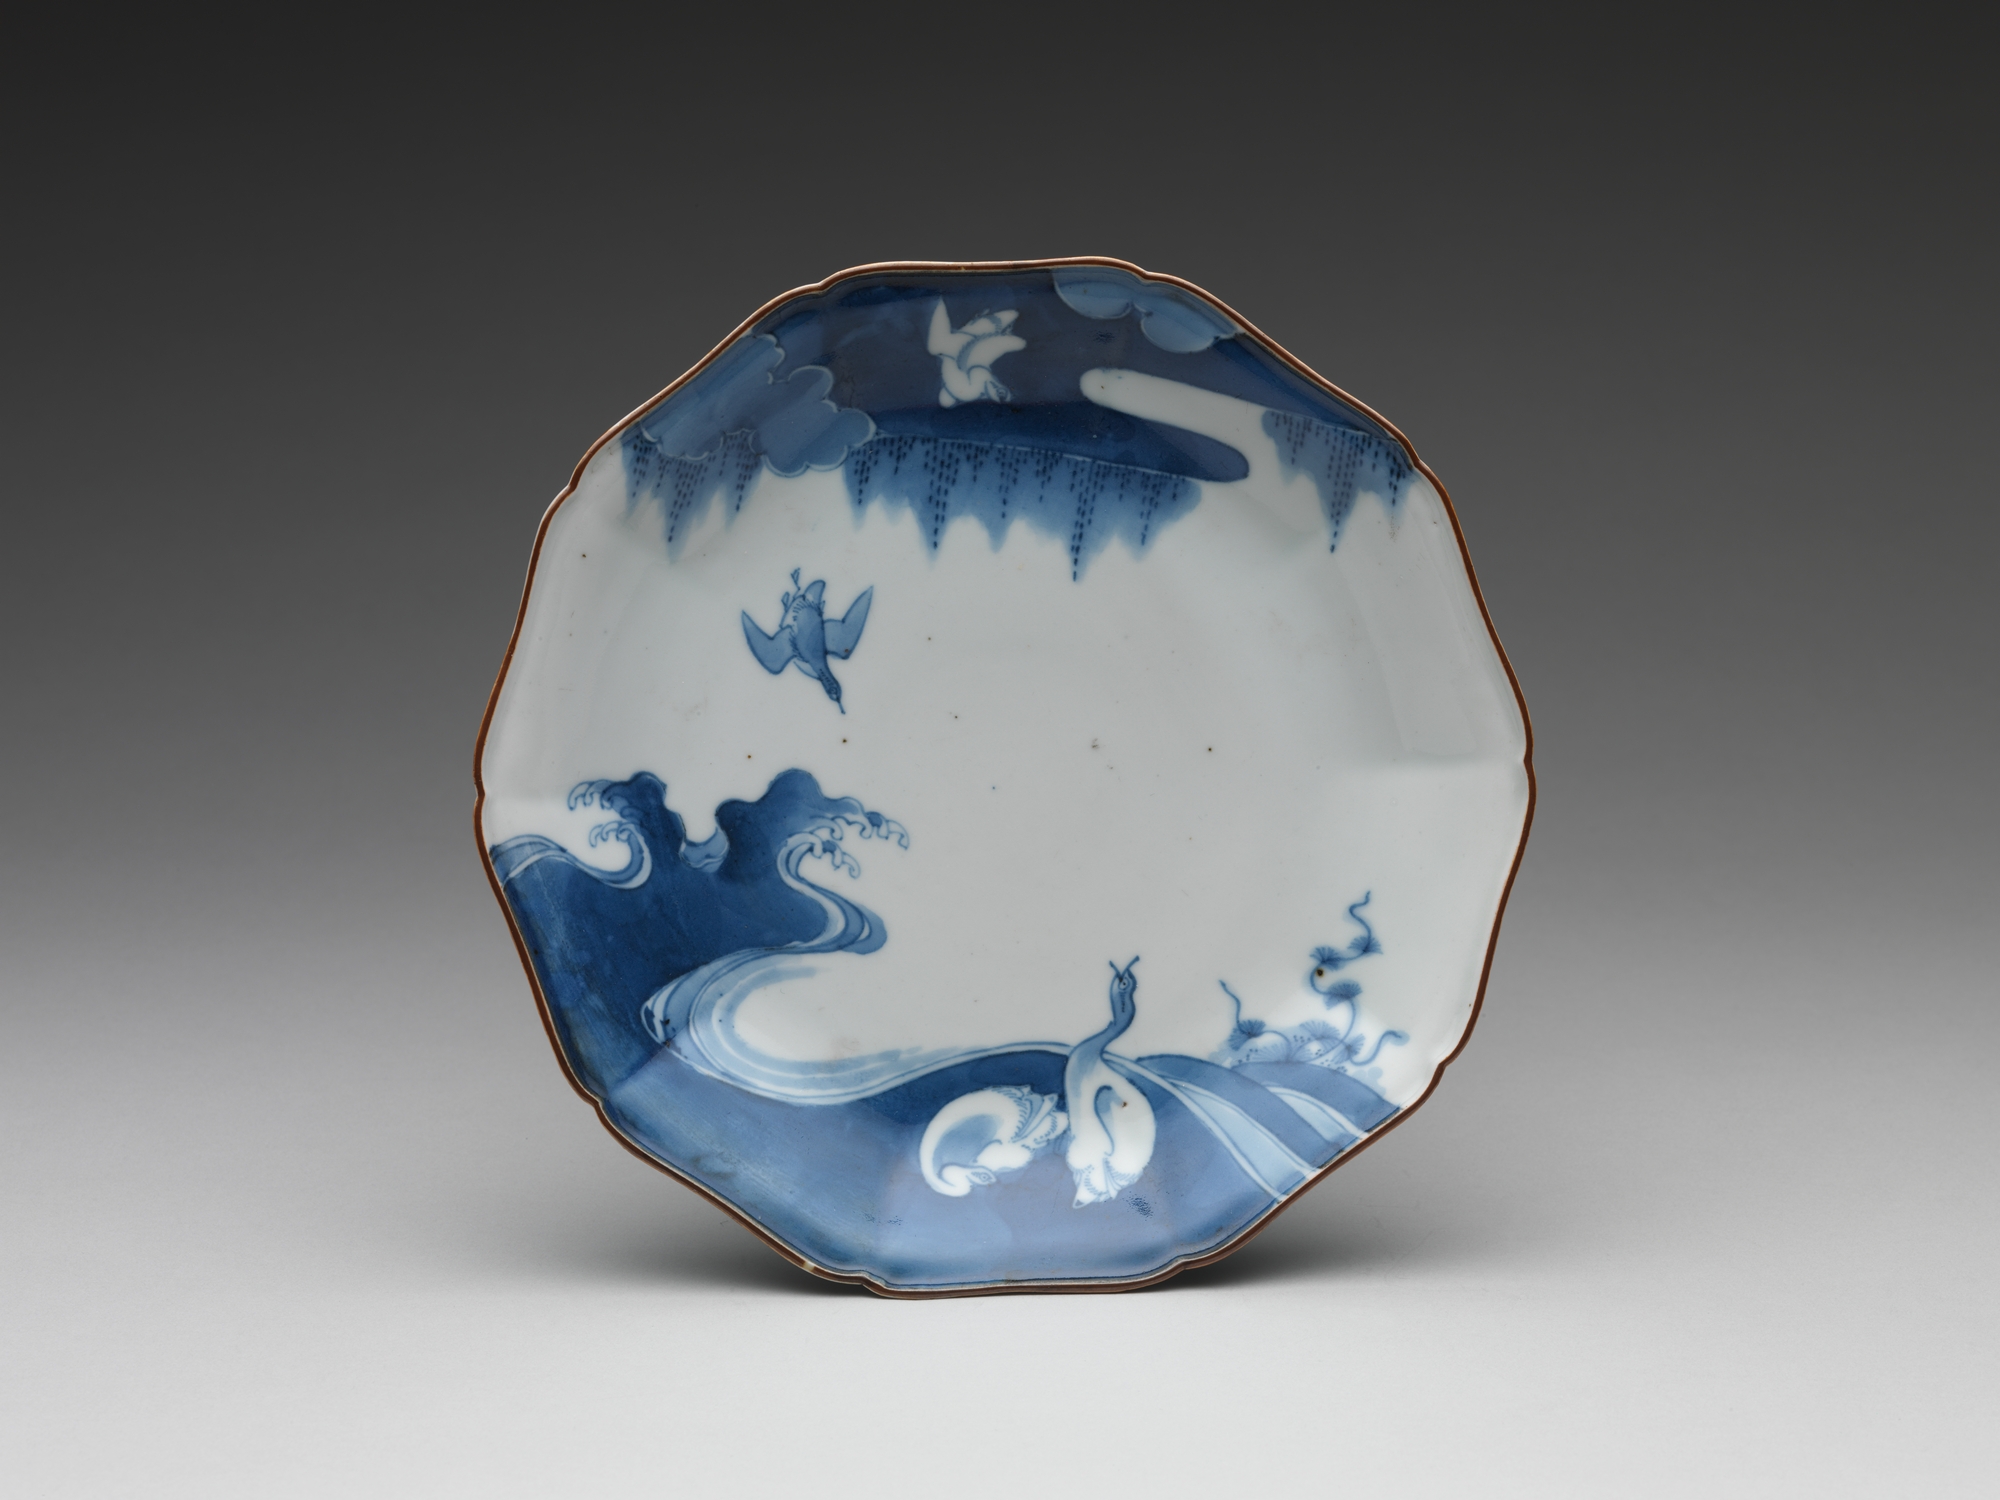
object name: plate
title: Plate with Geese and Waves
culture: japanese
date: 1700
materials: porcelain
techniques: underglaze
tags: birds